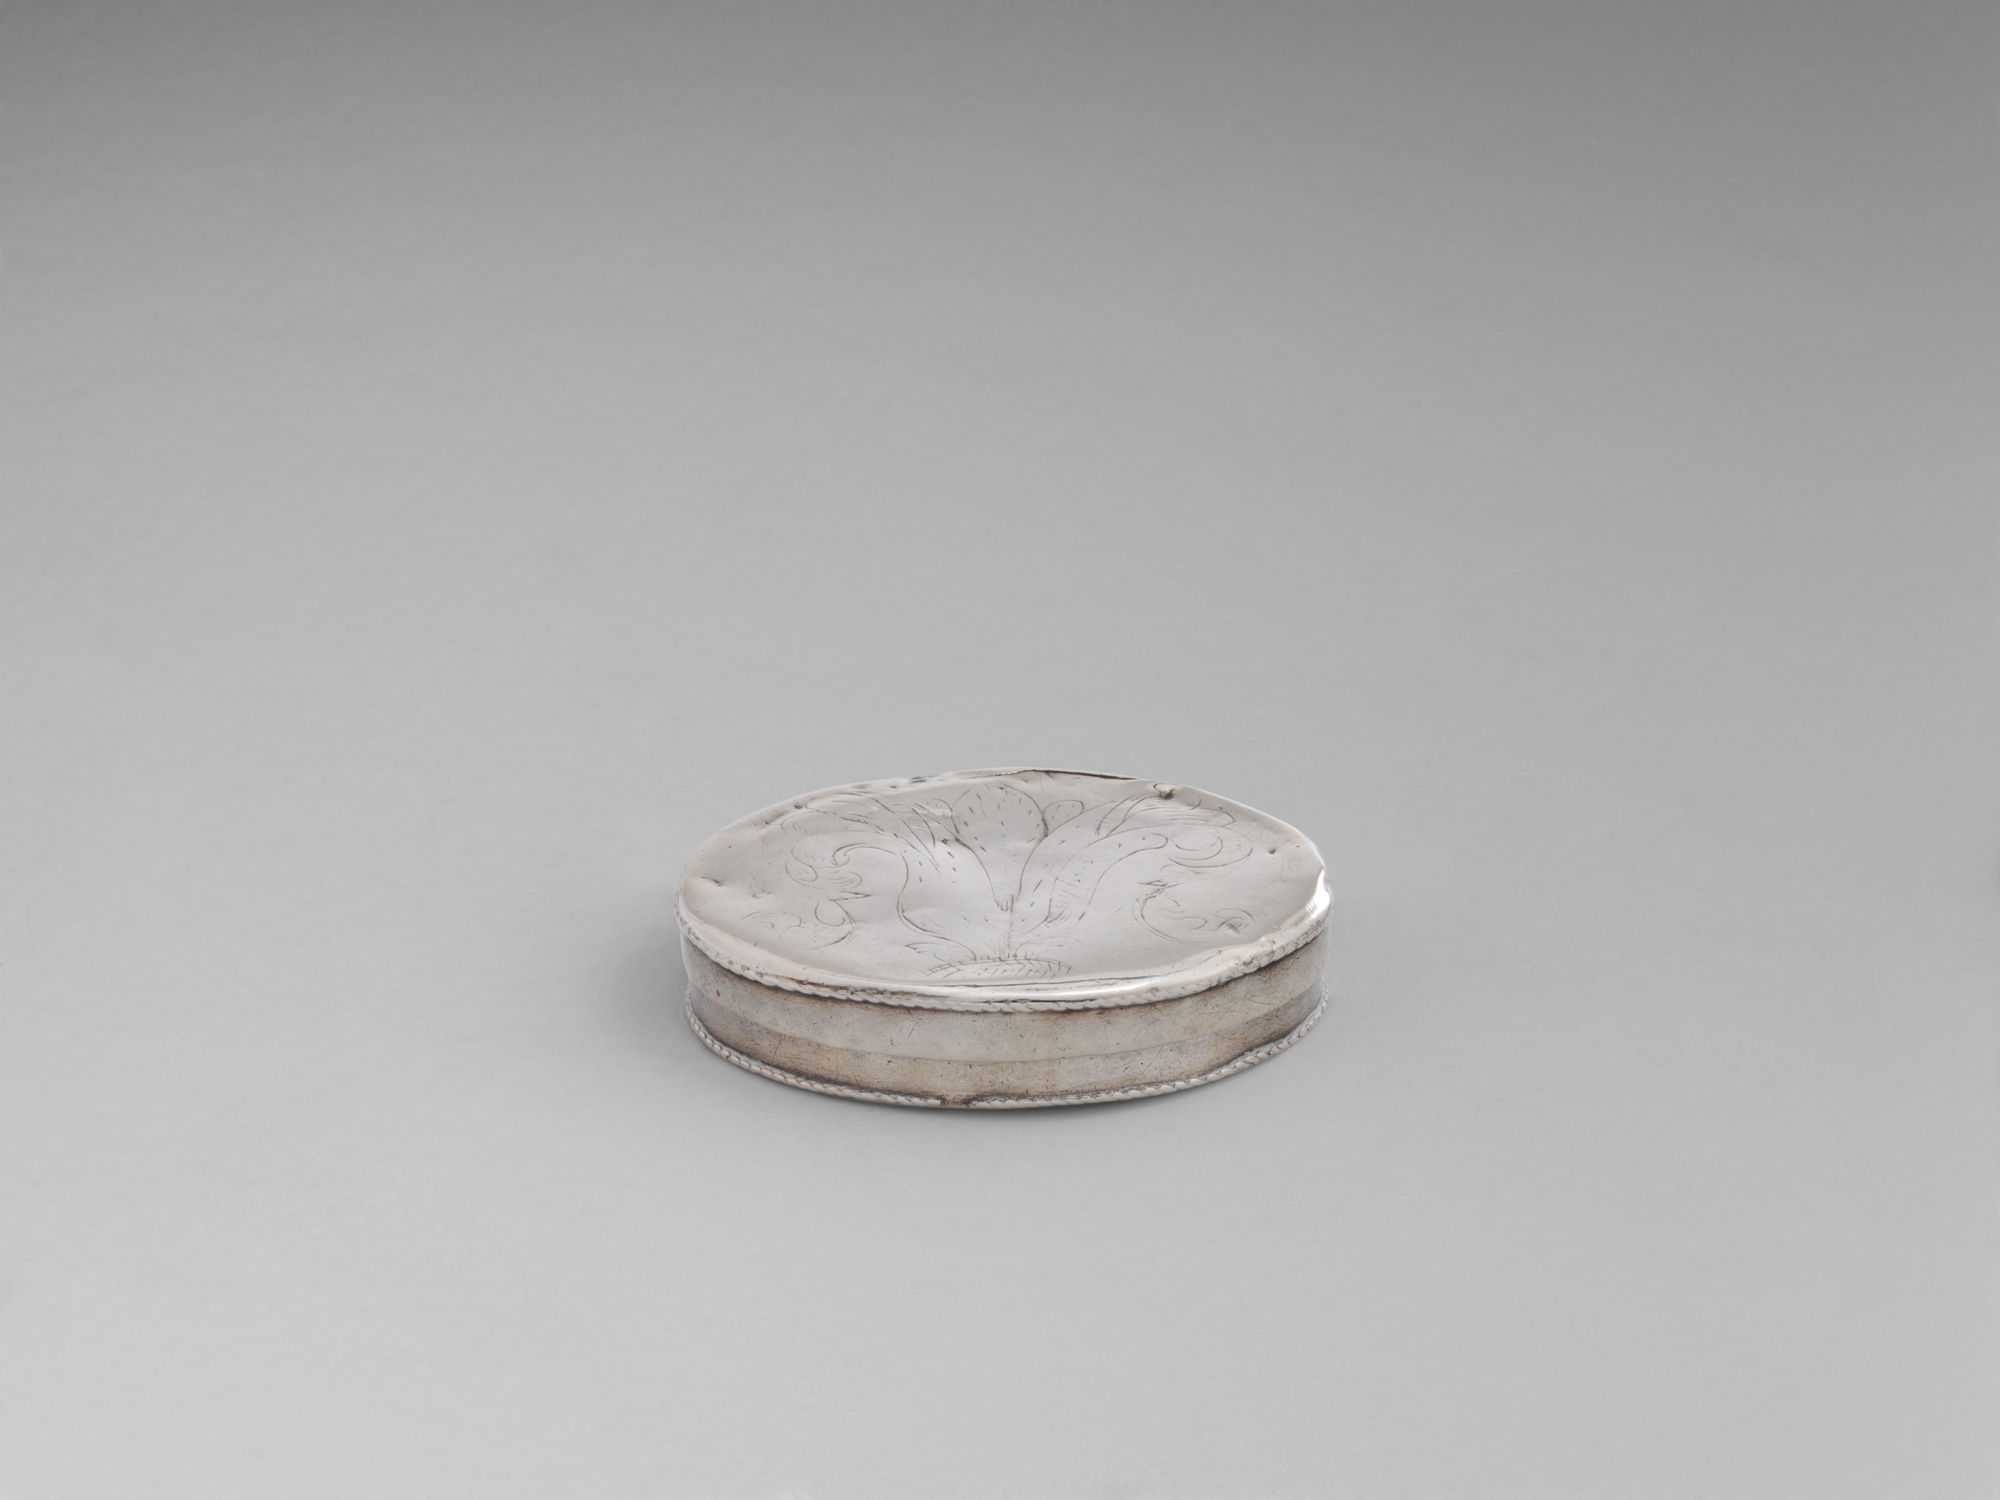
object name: patch box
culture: american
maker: william cowell sr.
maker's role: maker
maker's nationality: american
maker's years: 1682-1736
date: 1722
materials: silver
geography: united states